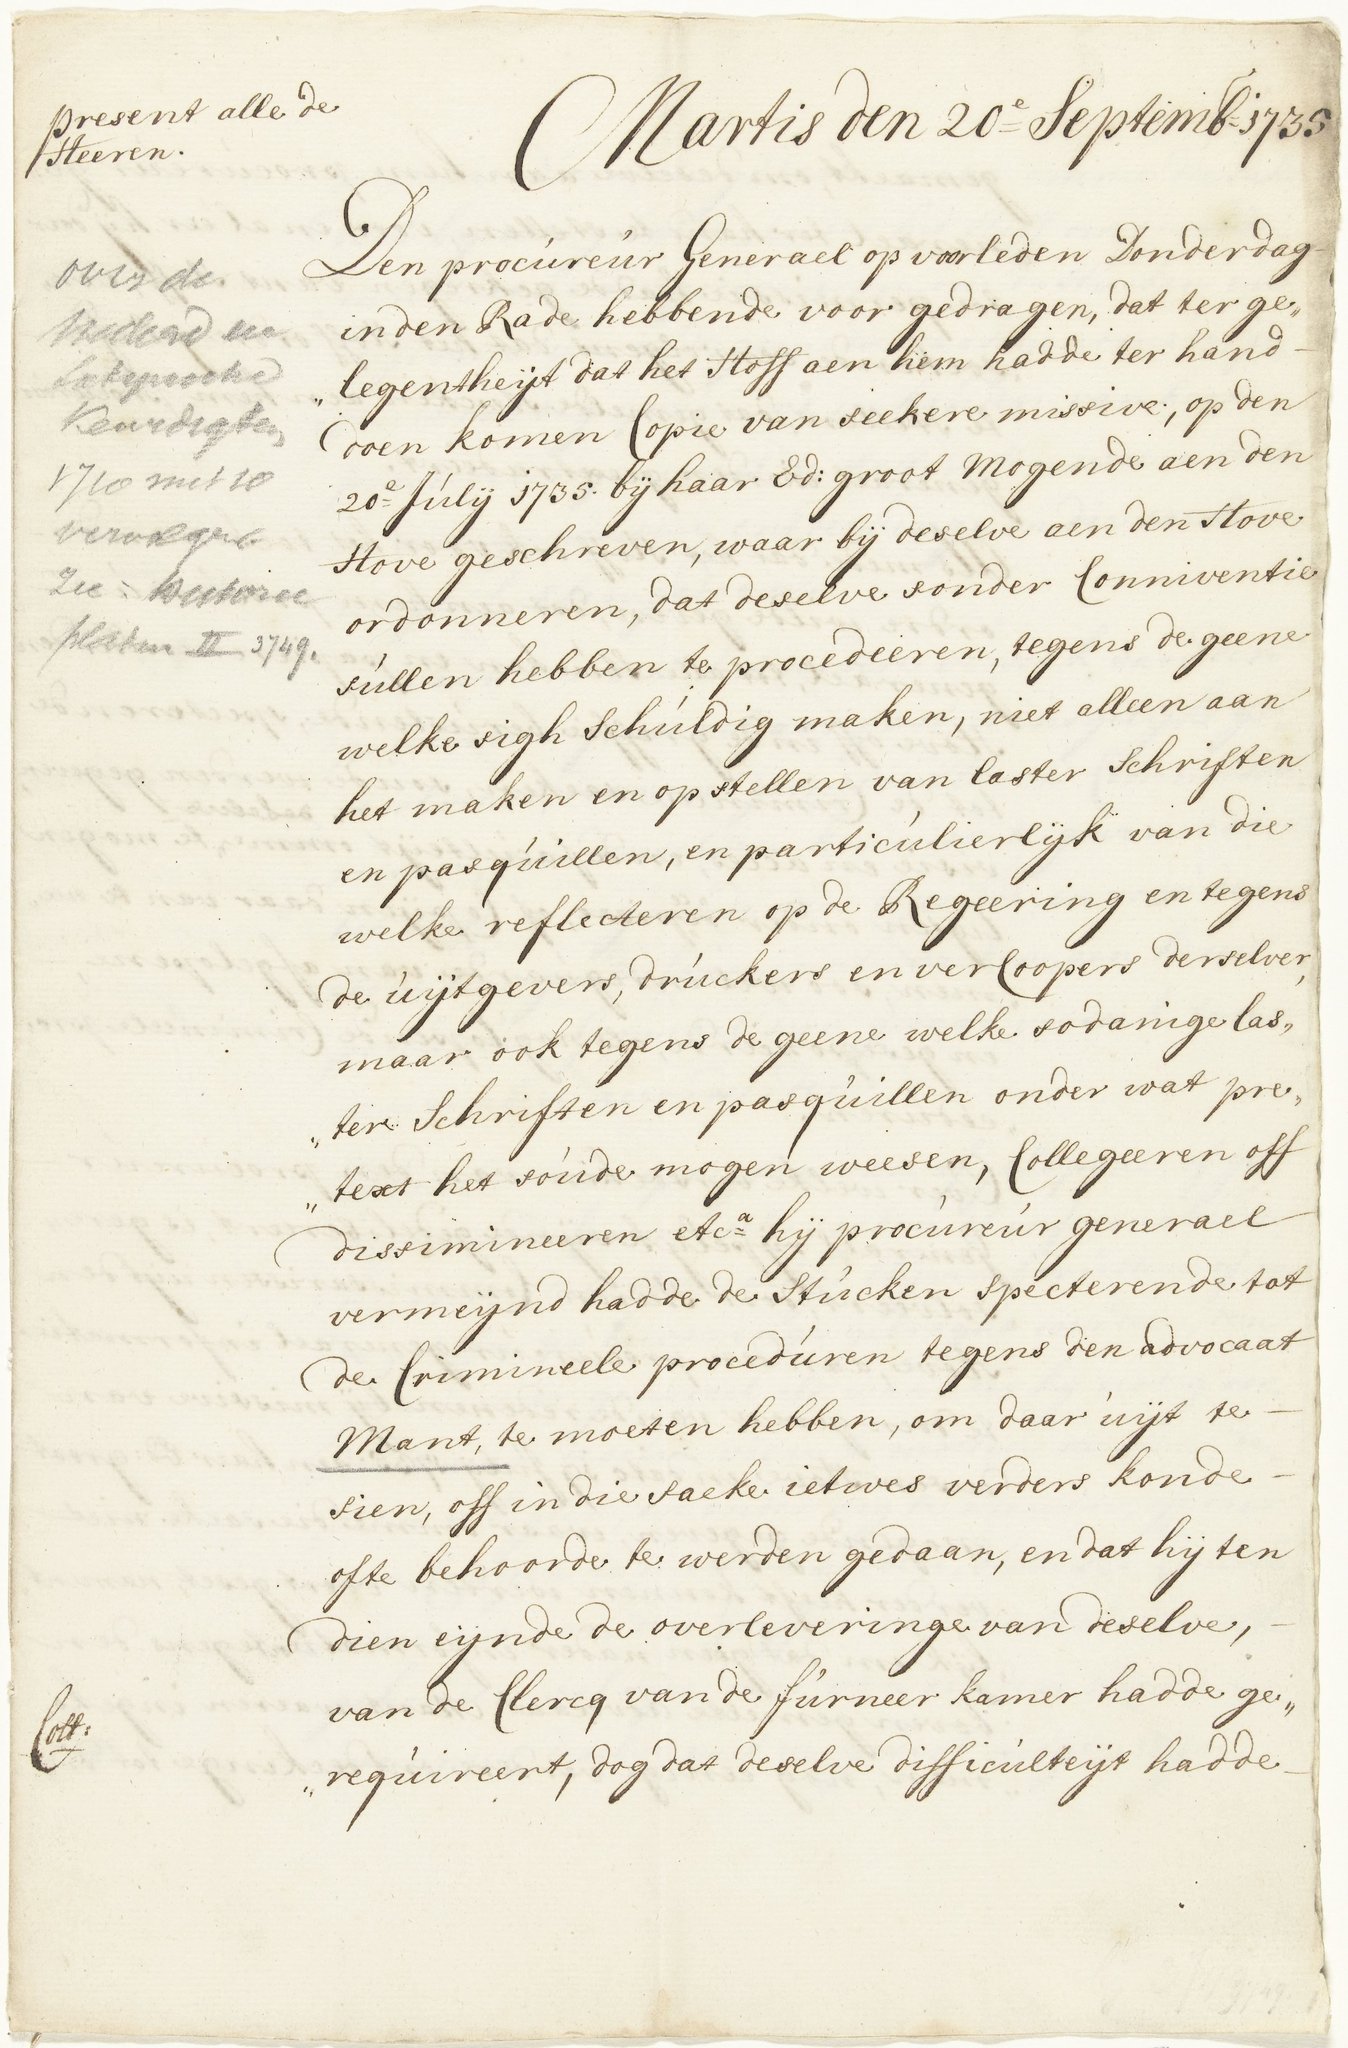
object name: manuscript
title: Afschrift van de resolutie over de vervolging van de uitgever van de Latynsche en Nederduitsche keurdichten, 1735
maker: Anonymous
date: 1735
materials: paper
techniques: writing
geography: northern netherlands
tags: willem iv (prins van oranje-nassau)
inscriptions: collector's mark: Lugt 2228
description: Afschrift van de resolutie van het Hof van Holland over de vervolging van de uitgever van de Latynsche en Nederduitsche keurdichten, op last van de Staten van Holland, 20 september 1735. Twee dubbelgevouwen bladen, beschreven op vier bladzijden. Wegens de publicatie van de spotprent op prins Willem IV.